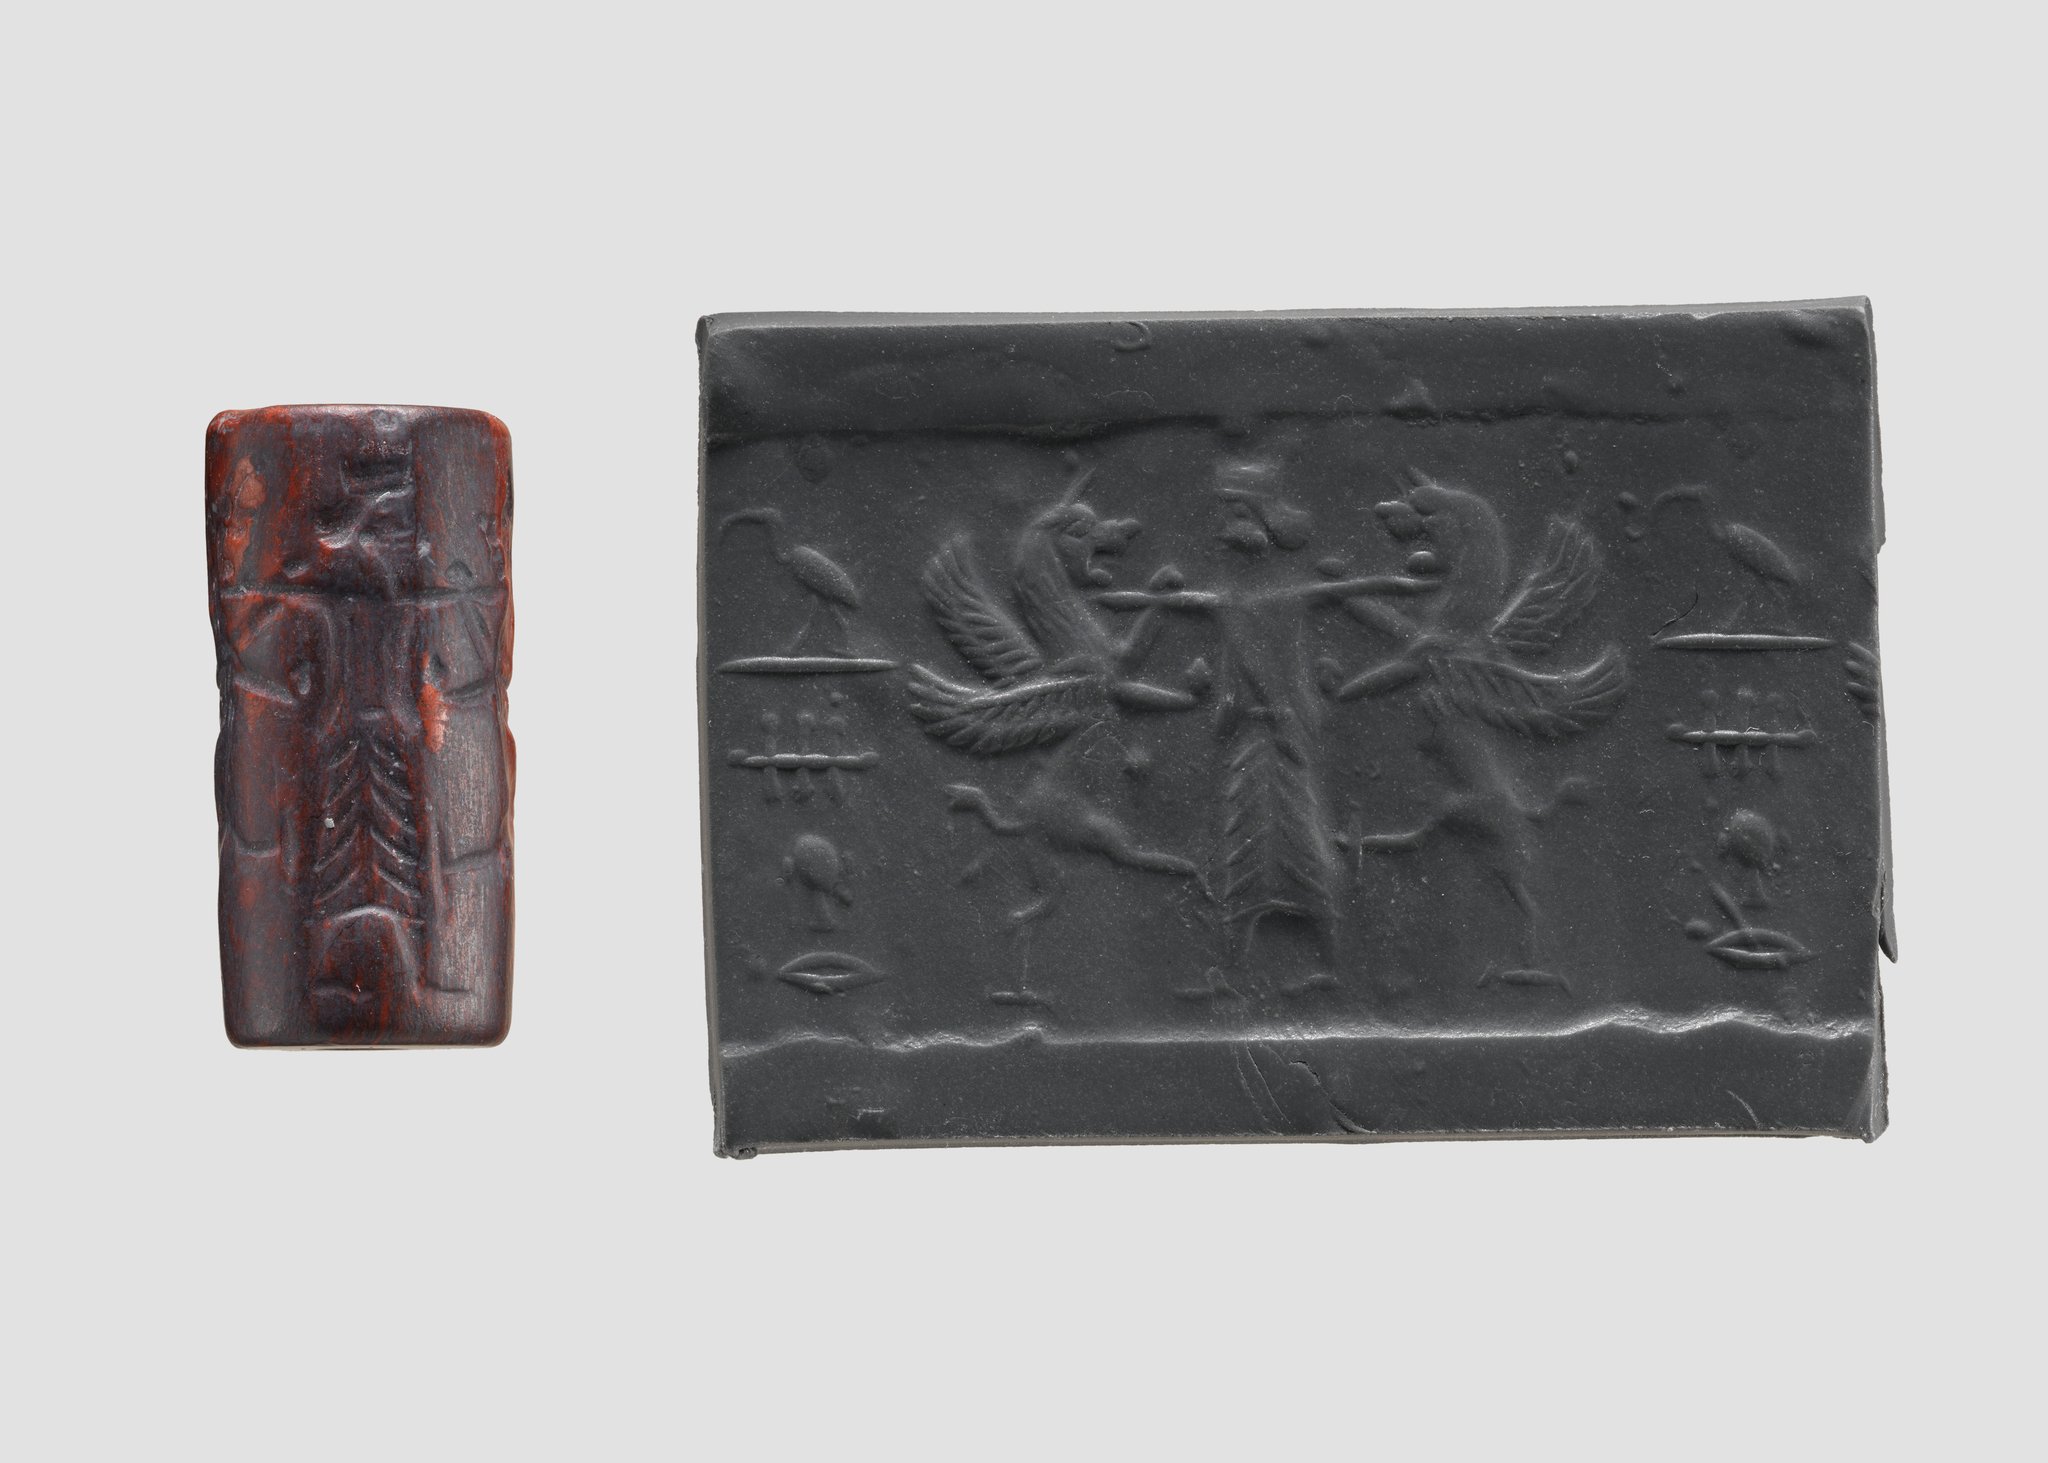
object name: cylinder seal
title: Cylinder seal and modern impression: king holding two lion griffins at bay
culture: achaemenid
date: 600-401 BCE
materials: mineral, jasper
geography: iran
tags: kings,griffins